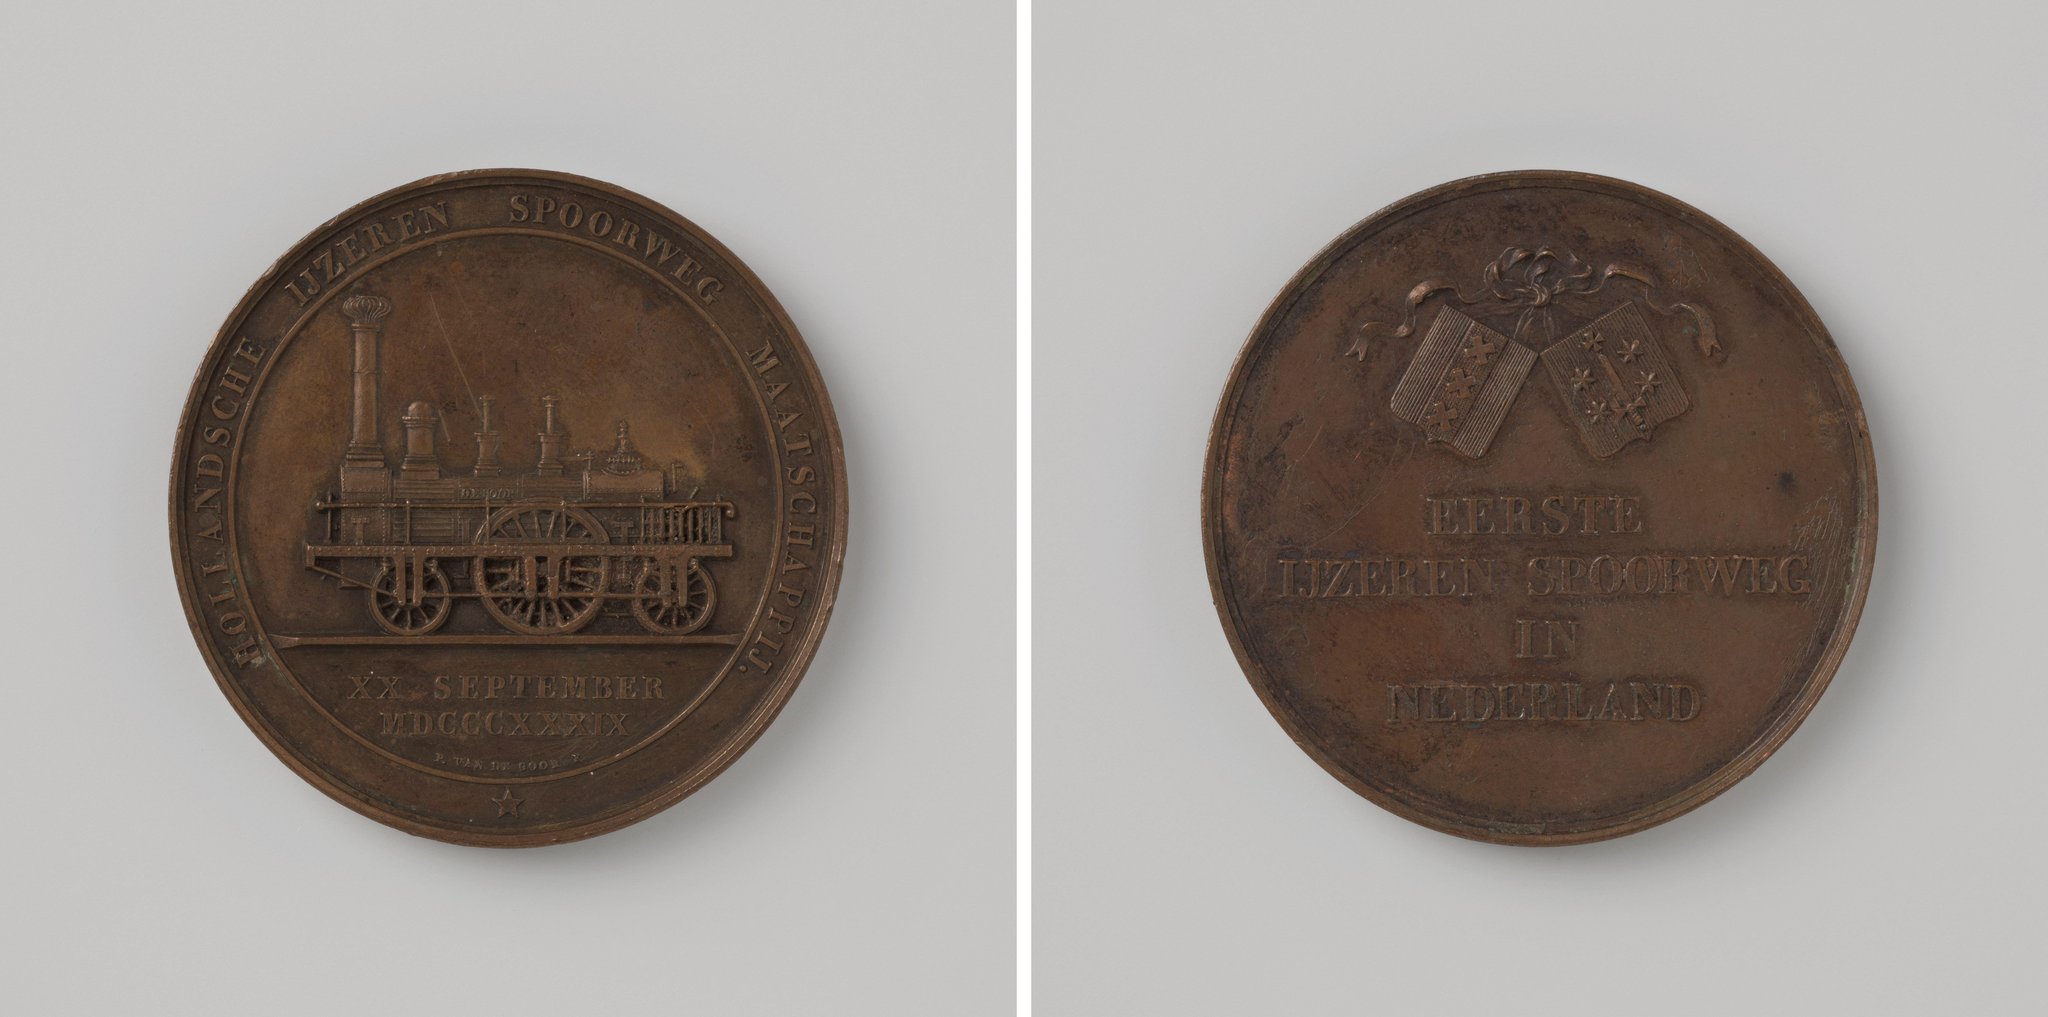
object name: history medal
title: Opening van de spoorweg Haarlem-Amsterdam 1839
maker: pierre wautier van de goor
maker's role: medailleur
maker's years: 1783-1851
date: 1839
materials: bronze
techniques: striking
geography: utrecht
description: Bronzen penning, op de voorzijde locomotief De Hoop, met omschrift en afsnedetekst, op de keerzijde vier regels tekst onder de samengestrikte wapenschilden van Amsterdam en Haarlem.